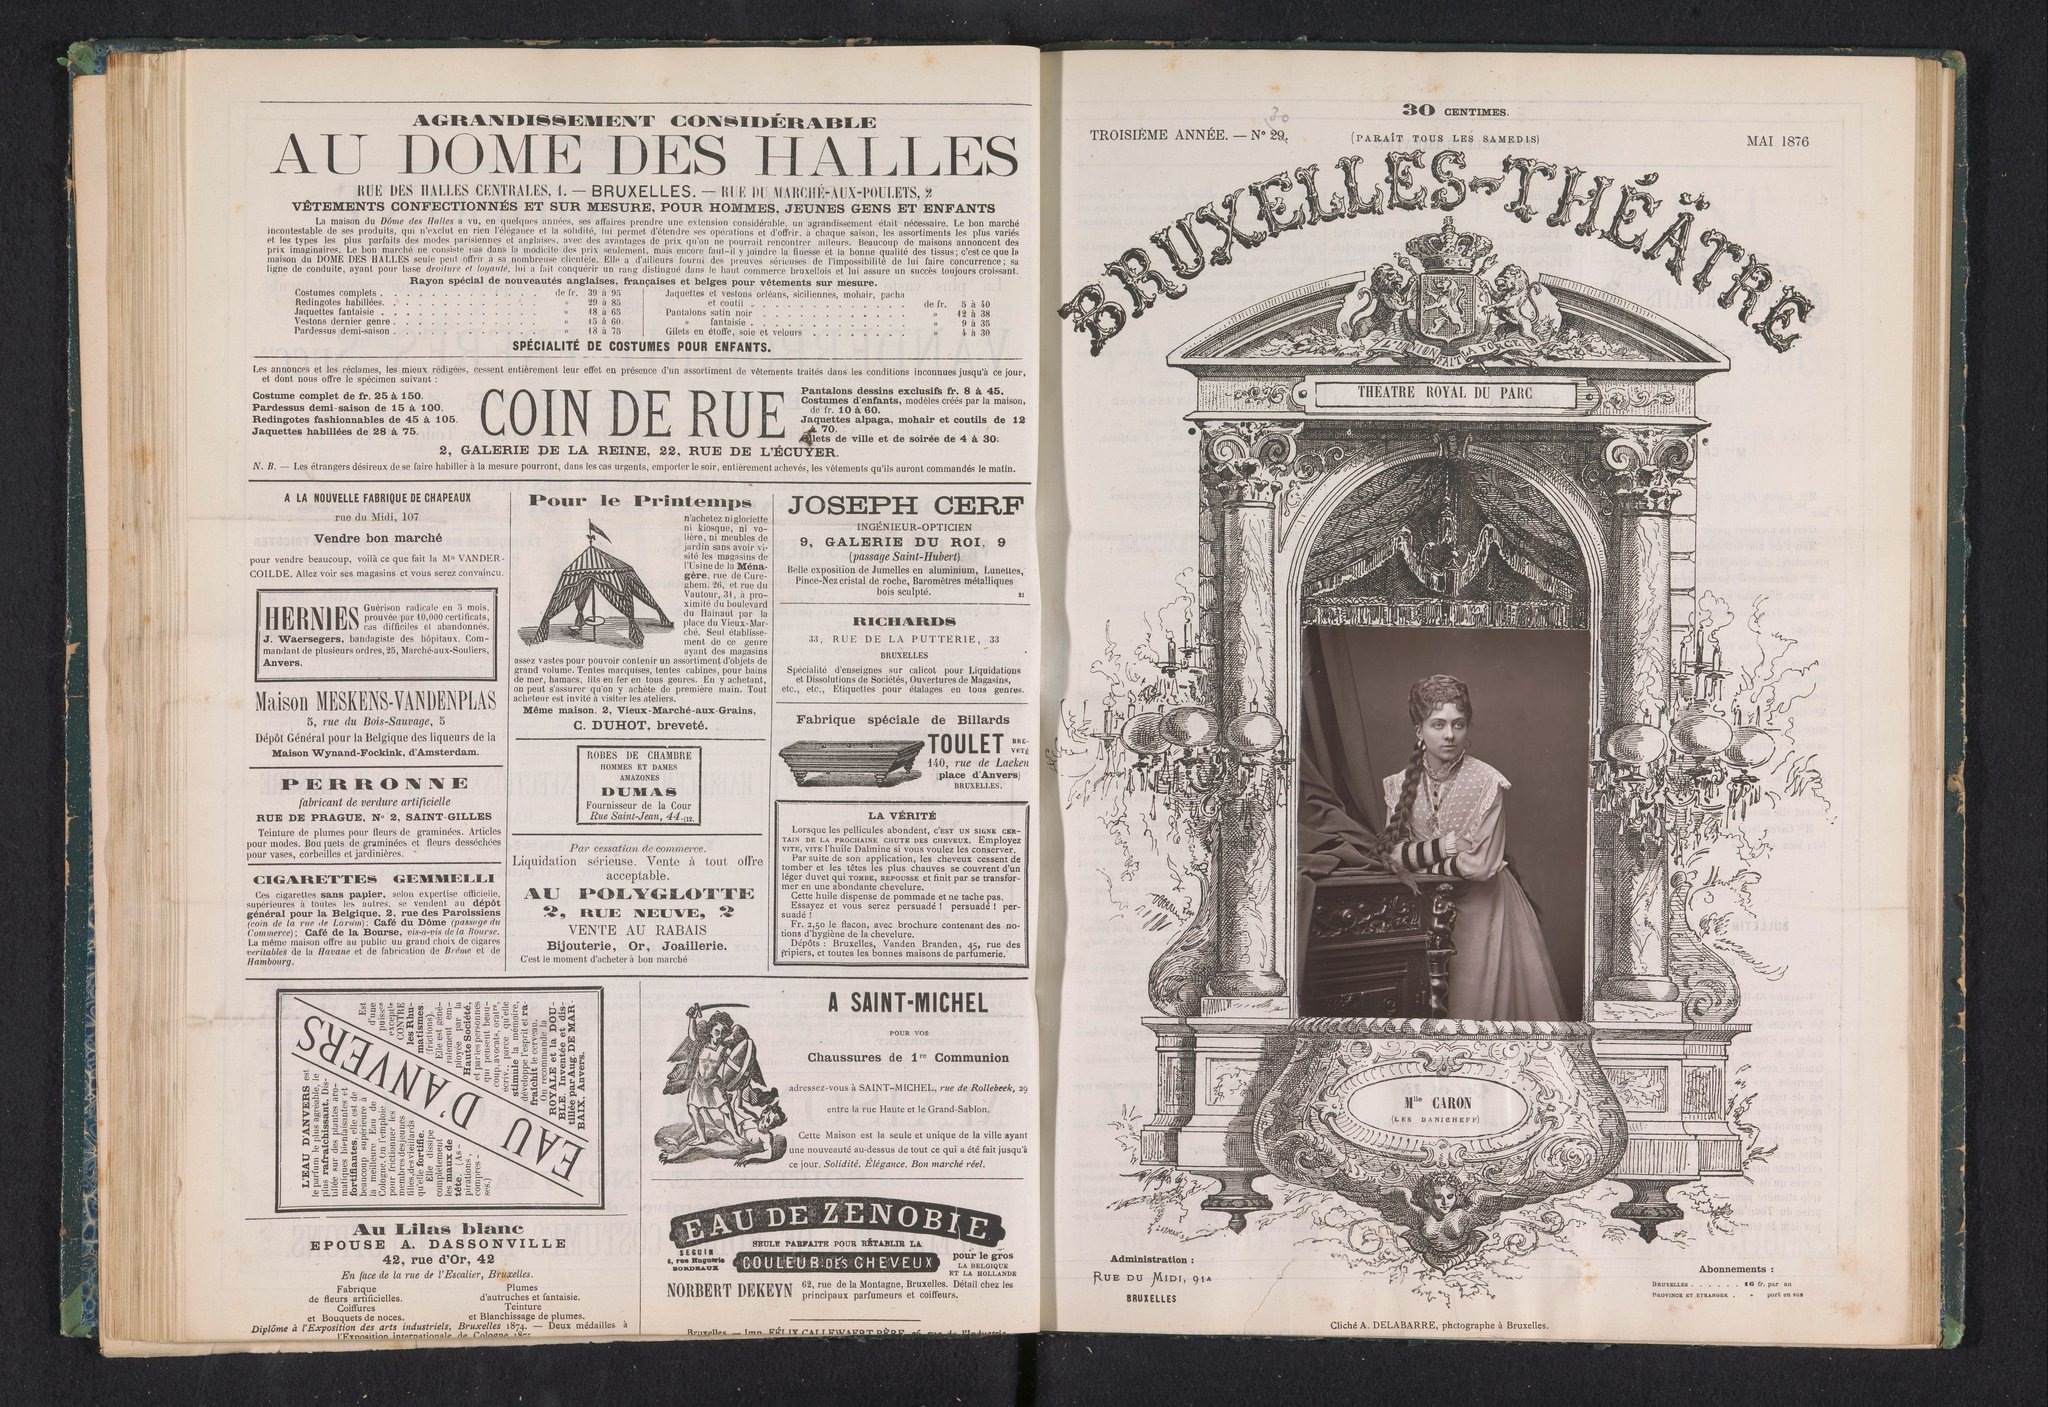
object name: photomechanical print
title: Mlle Caron (Les danicheff)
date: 1871-1876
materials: paper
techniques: woodburytype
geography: brussels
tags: portrait of actor, actress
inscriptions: number: ‘No 30.’